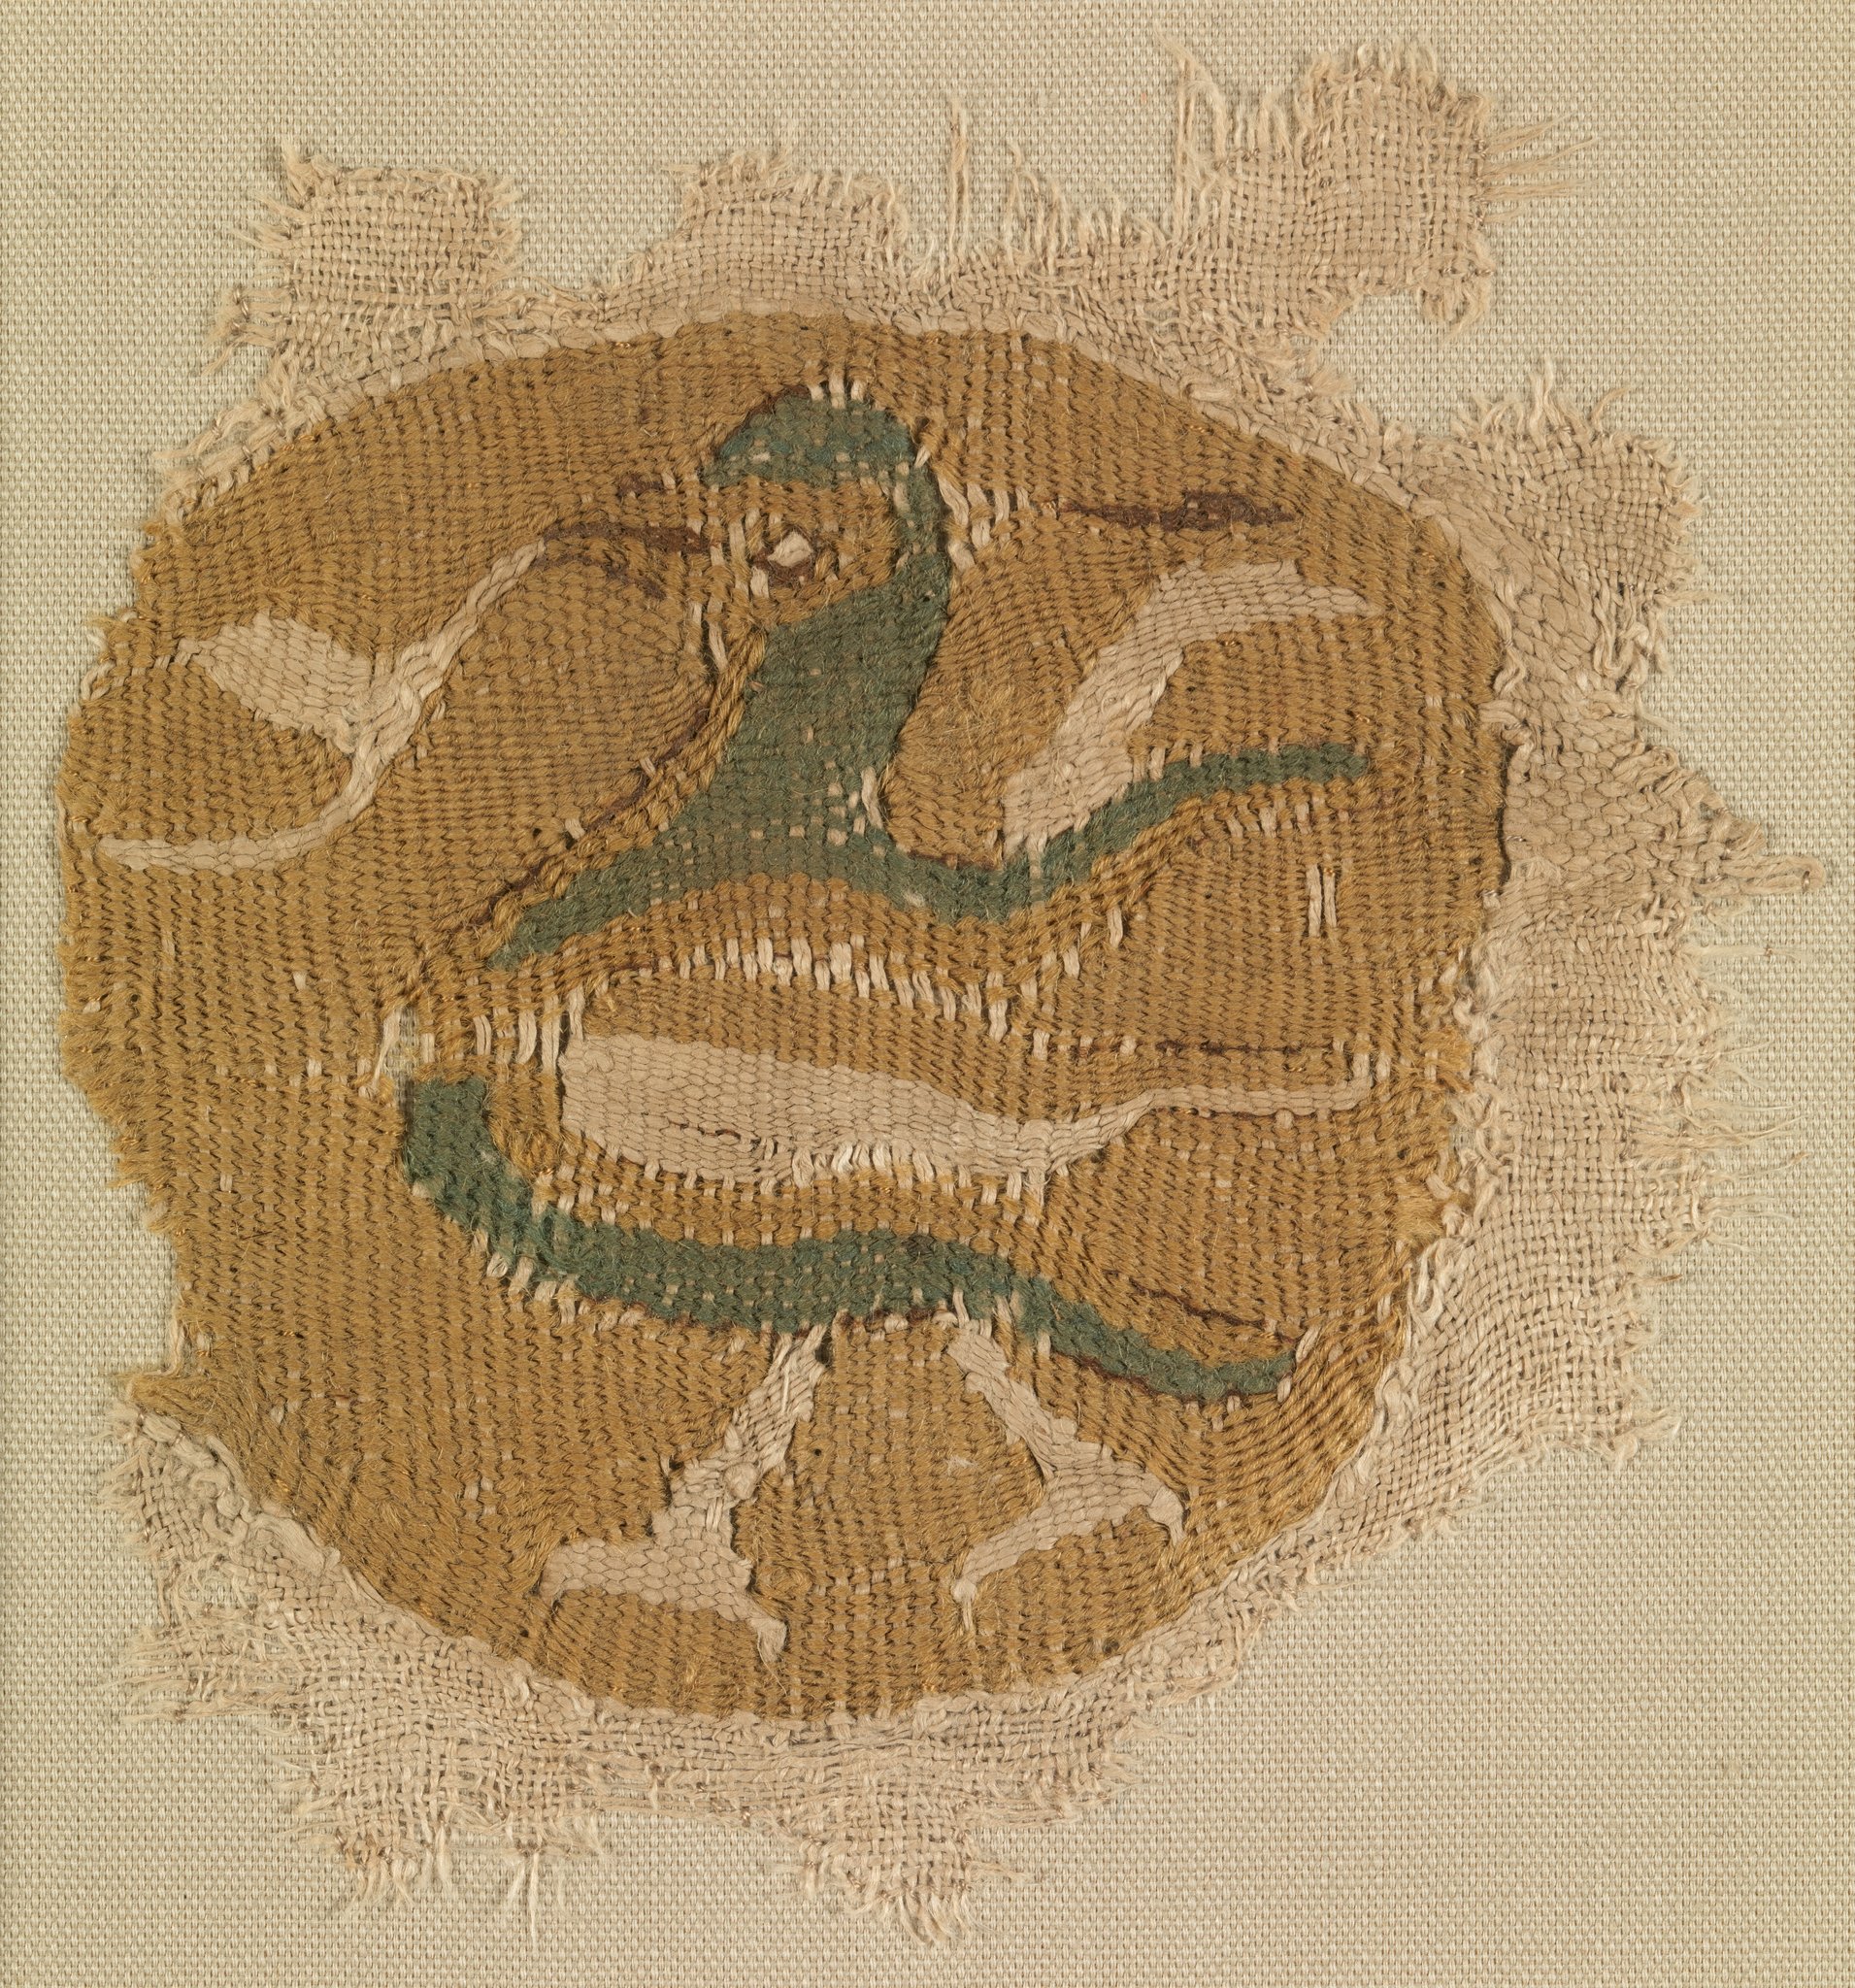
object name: textile fragment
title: Roundel with Bird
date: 801-900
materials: linen, wool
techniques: tapestry, weave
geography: egypt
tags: birds